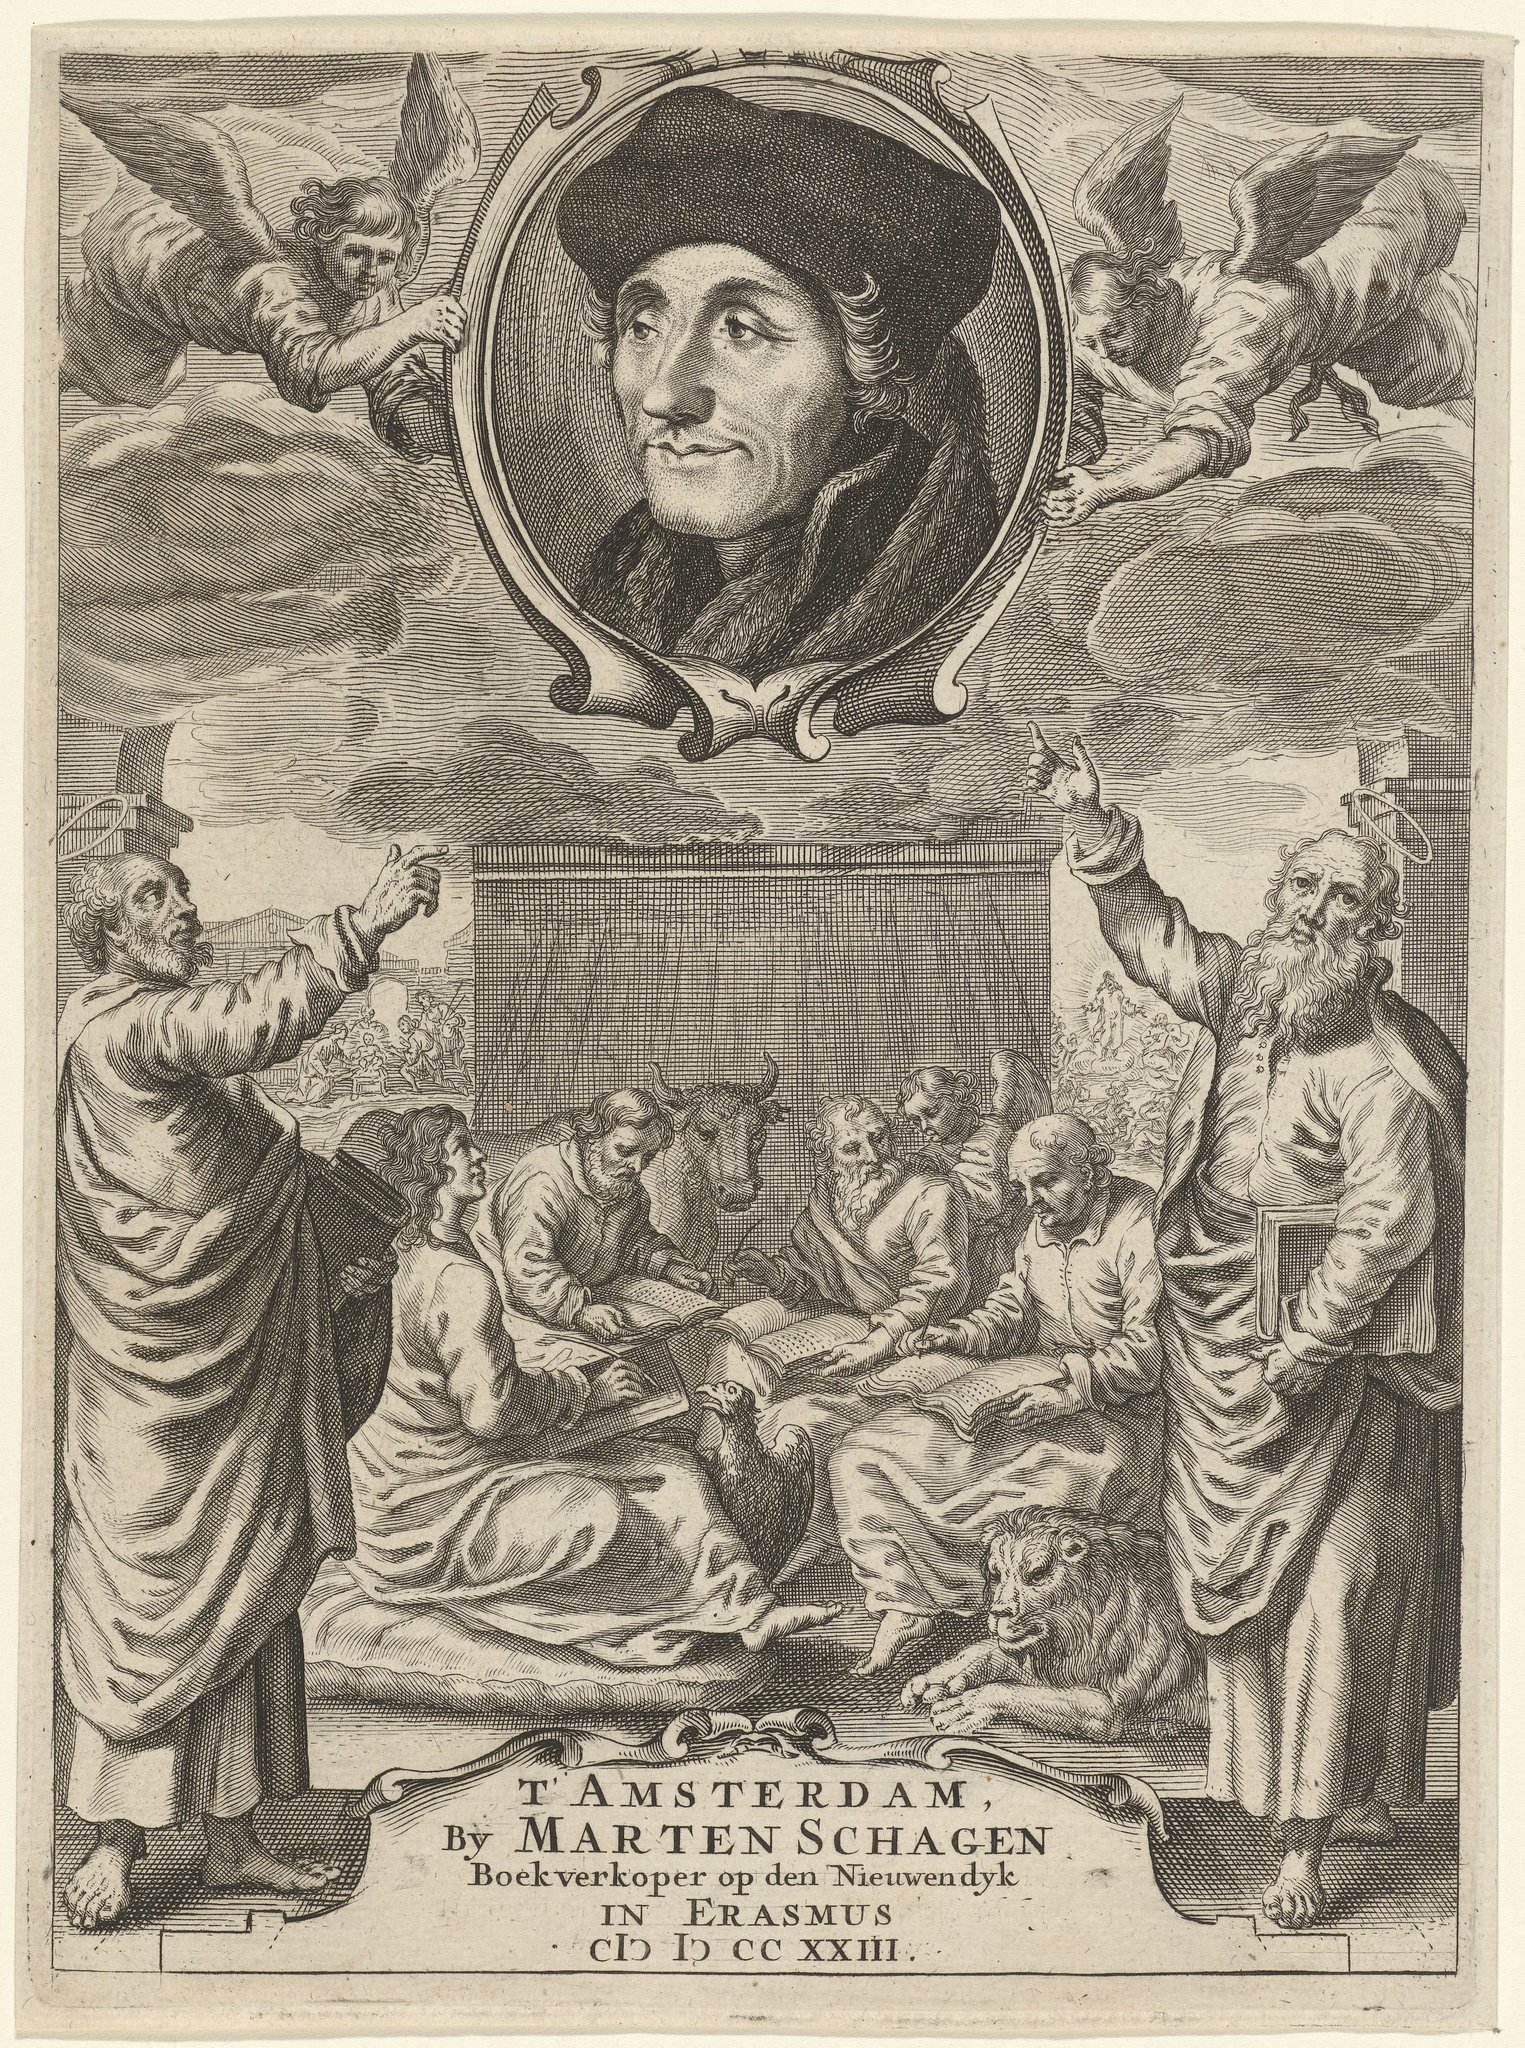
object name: print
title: Portret van Erasmus boven vier evangelisten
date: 1663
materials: paper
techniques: engraving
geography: amsterdam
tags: rotterdam, desiderius erasmus, the evangelists writing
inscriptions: collector's mark: Lugt 2228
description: De vier evangelisten met hun symbolen mens, leeuw, adelaar en os, terwijl zij schrijven. Op de voorgrond aan weerszijden twee mannenfiguren met aureool die naar boven wijzen, naar het portret van Desiderius Erasmus, dat wordt vastgehouden door twee engelen.